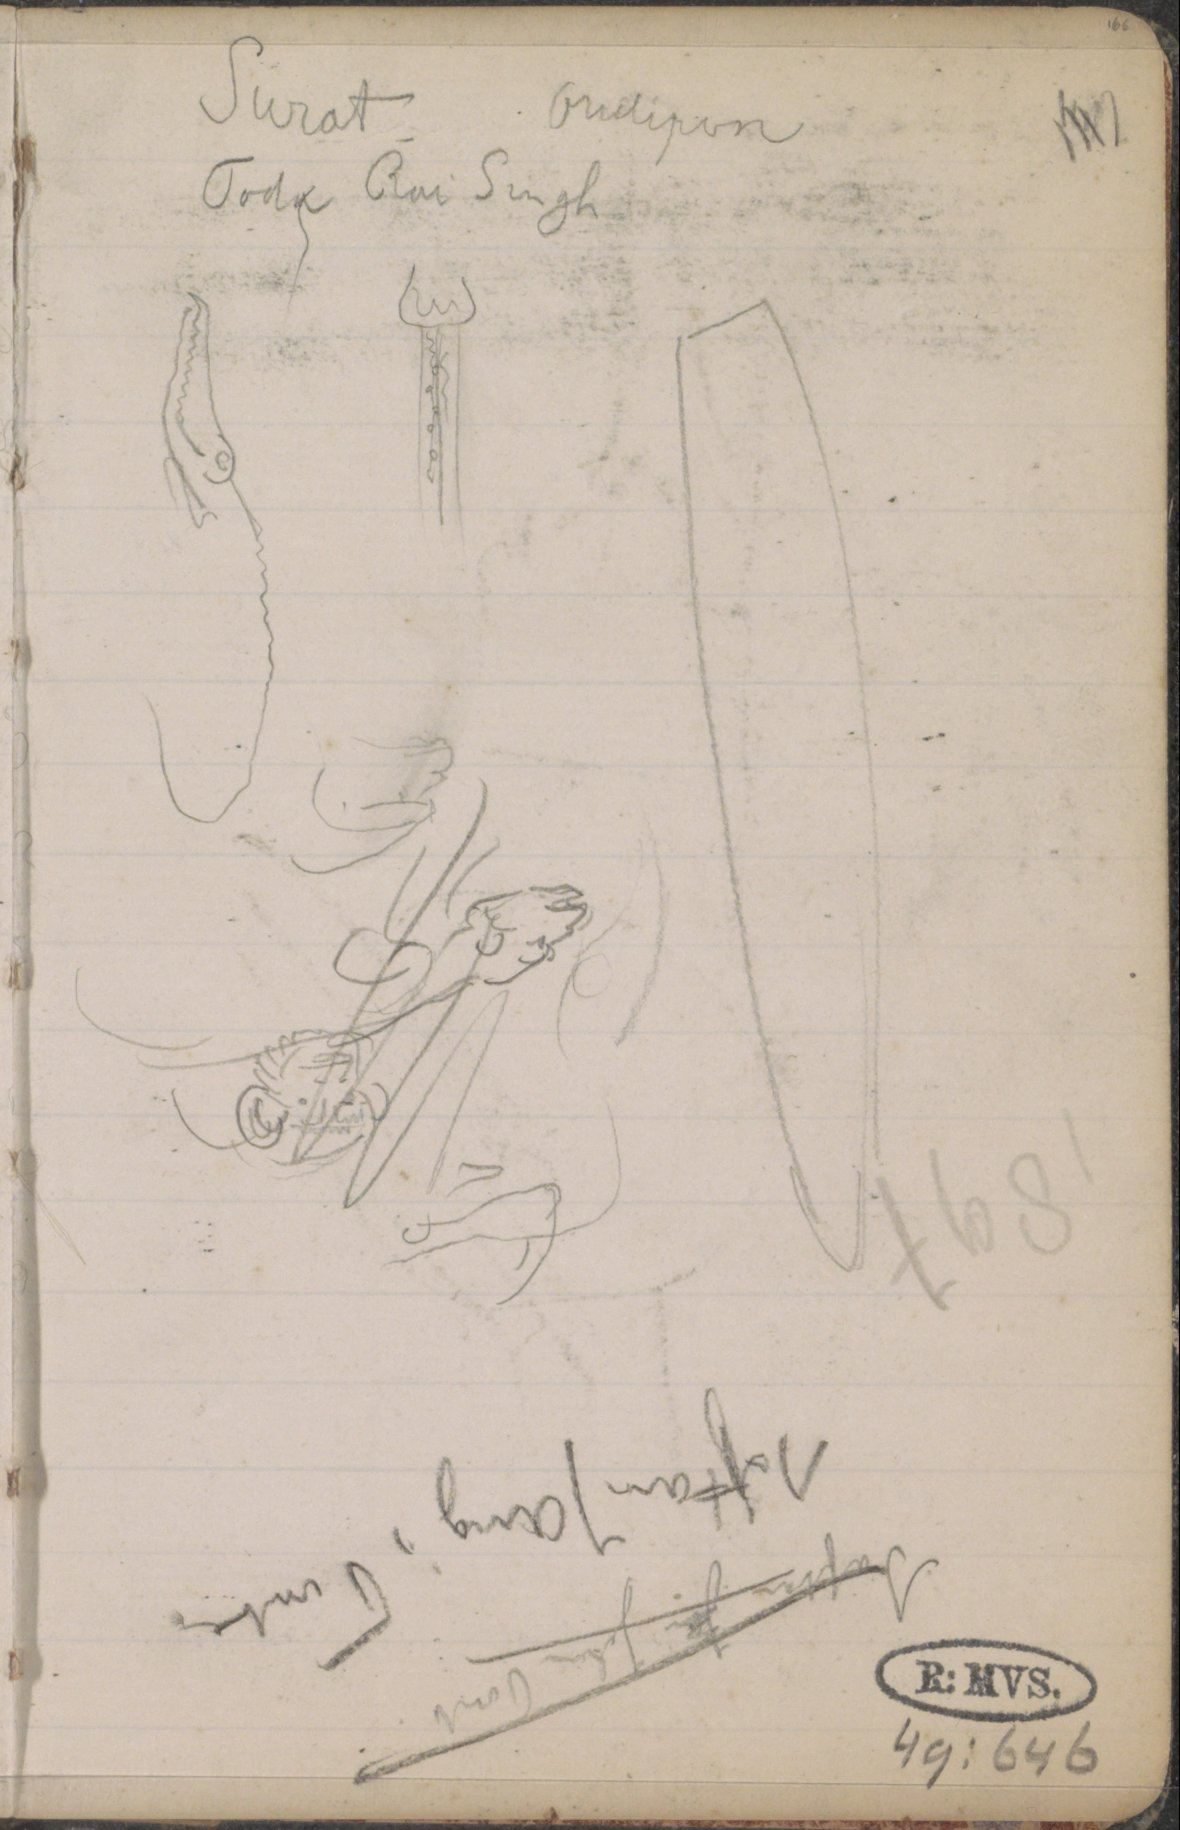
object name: sketchbook leaf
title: Koppen van apen en een krokodil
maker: marius bauer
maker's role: draughtsman, print maker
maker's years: 1867-1932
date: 1897-1898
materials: pencil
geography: india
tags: crocodiles: crocodile, monkeys, apes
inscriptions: collector's mark: Lugt 2228, date and inscription: ‘[...]/ softan Jang, Tinber/ 1897/ Surat ondipon/ Toda Rai Singh’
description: Pagina 166 uit een schetsboek met 84 bladen.